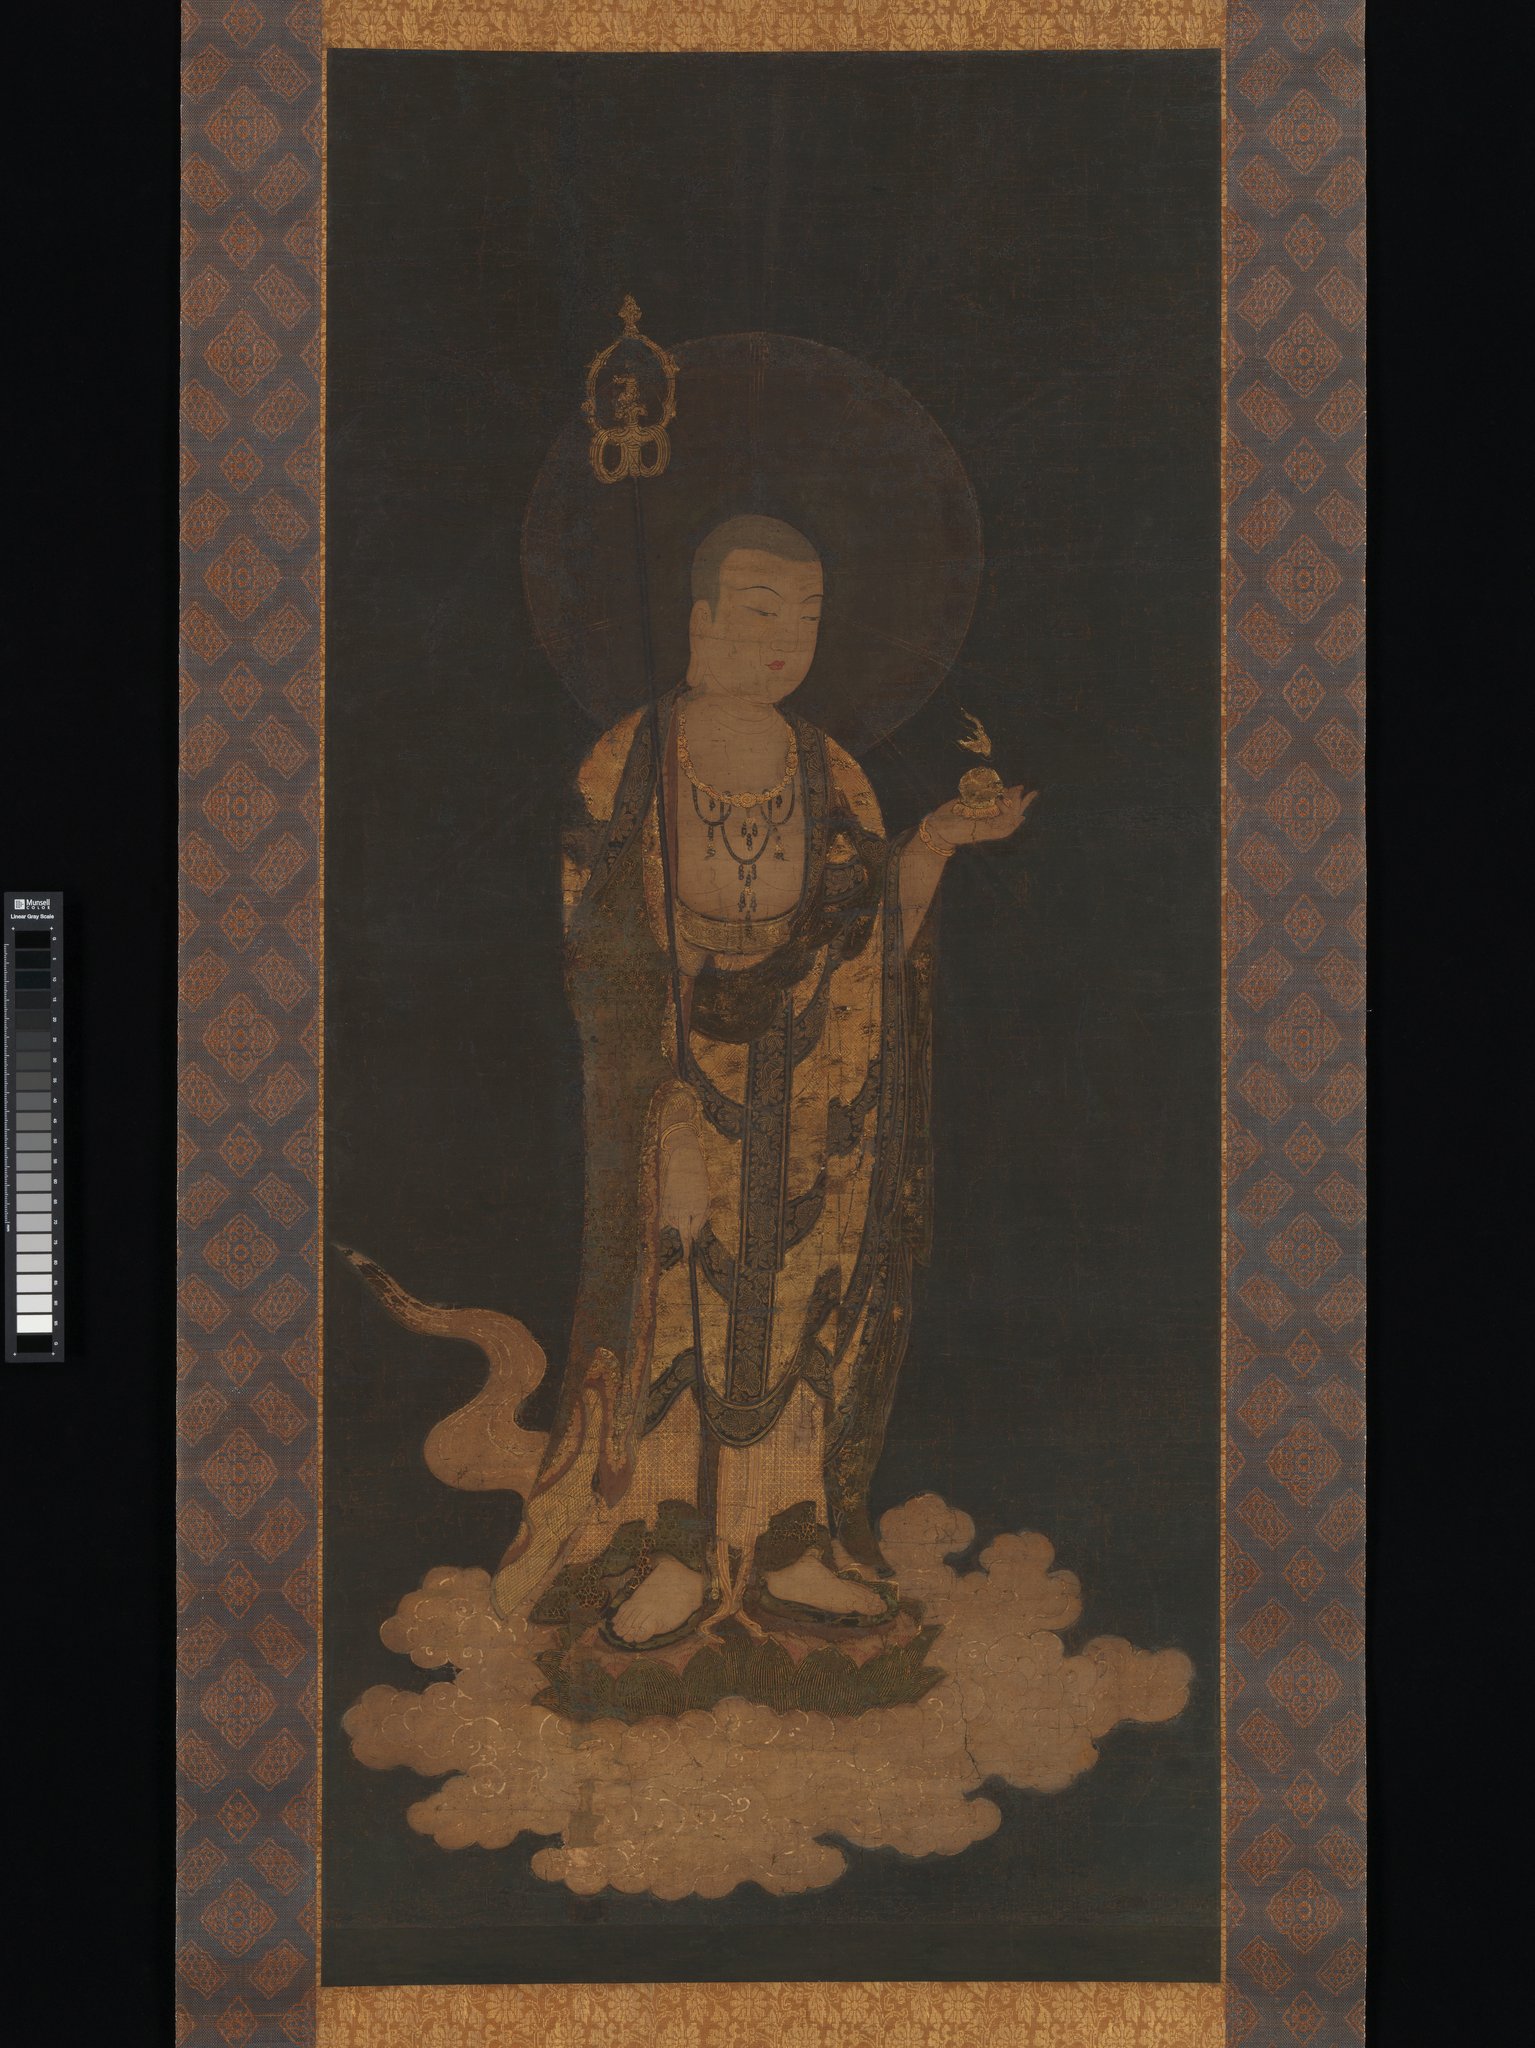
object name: hanging scroll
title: Jizō Bosatsu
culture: japanese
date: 1401-1500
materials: gold leaf, gold paint, ink, silk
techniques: cutting, kirikane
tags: bodhisattvas